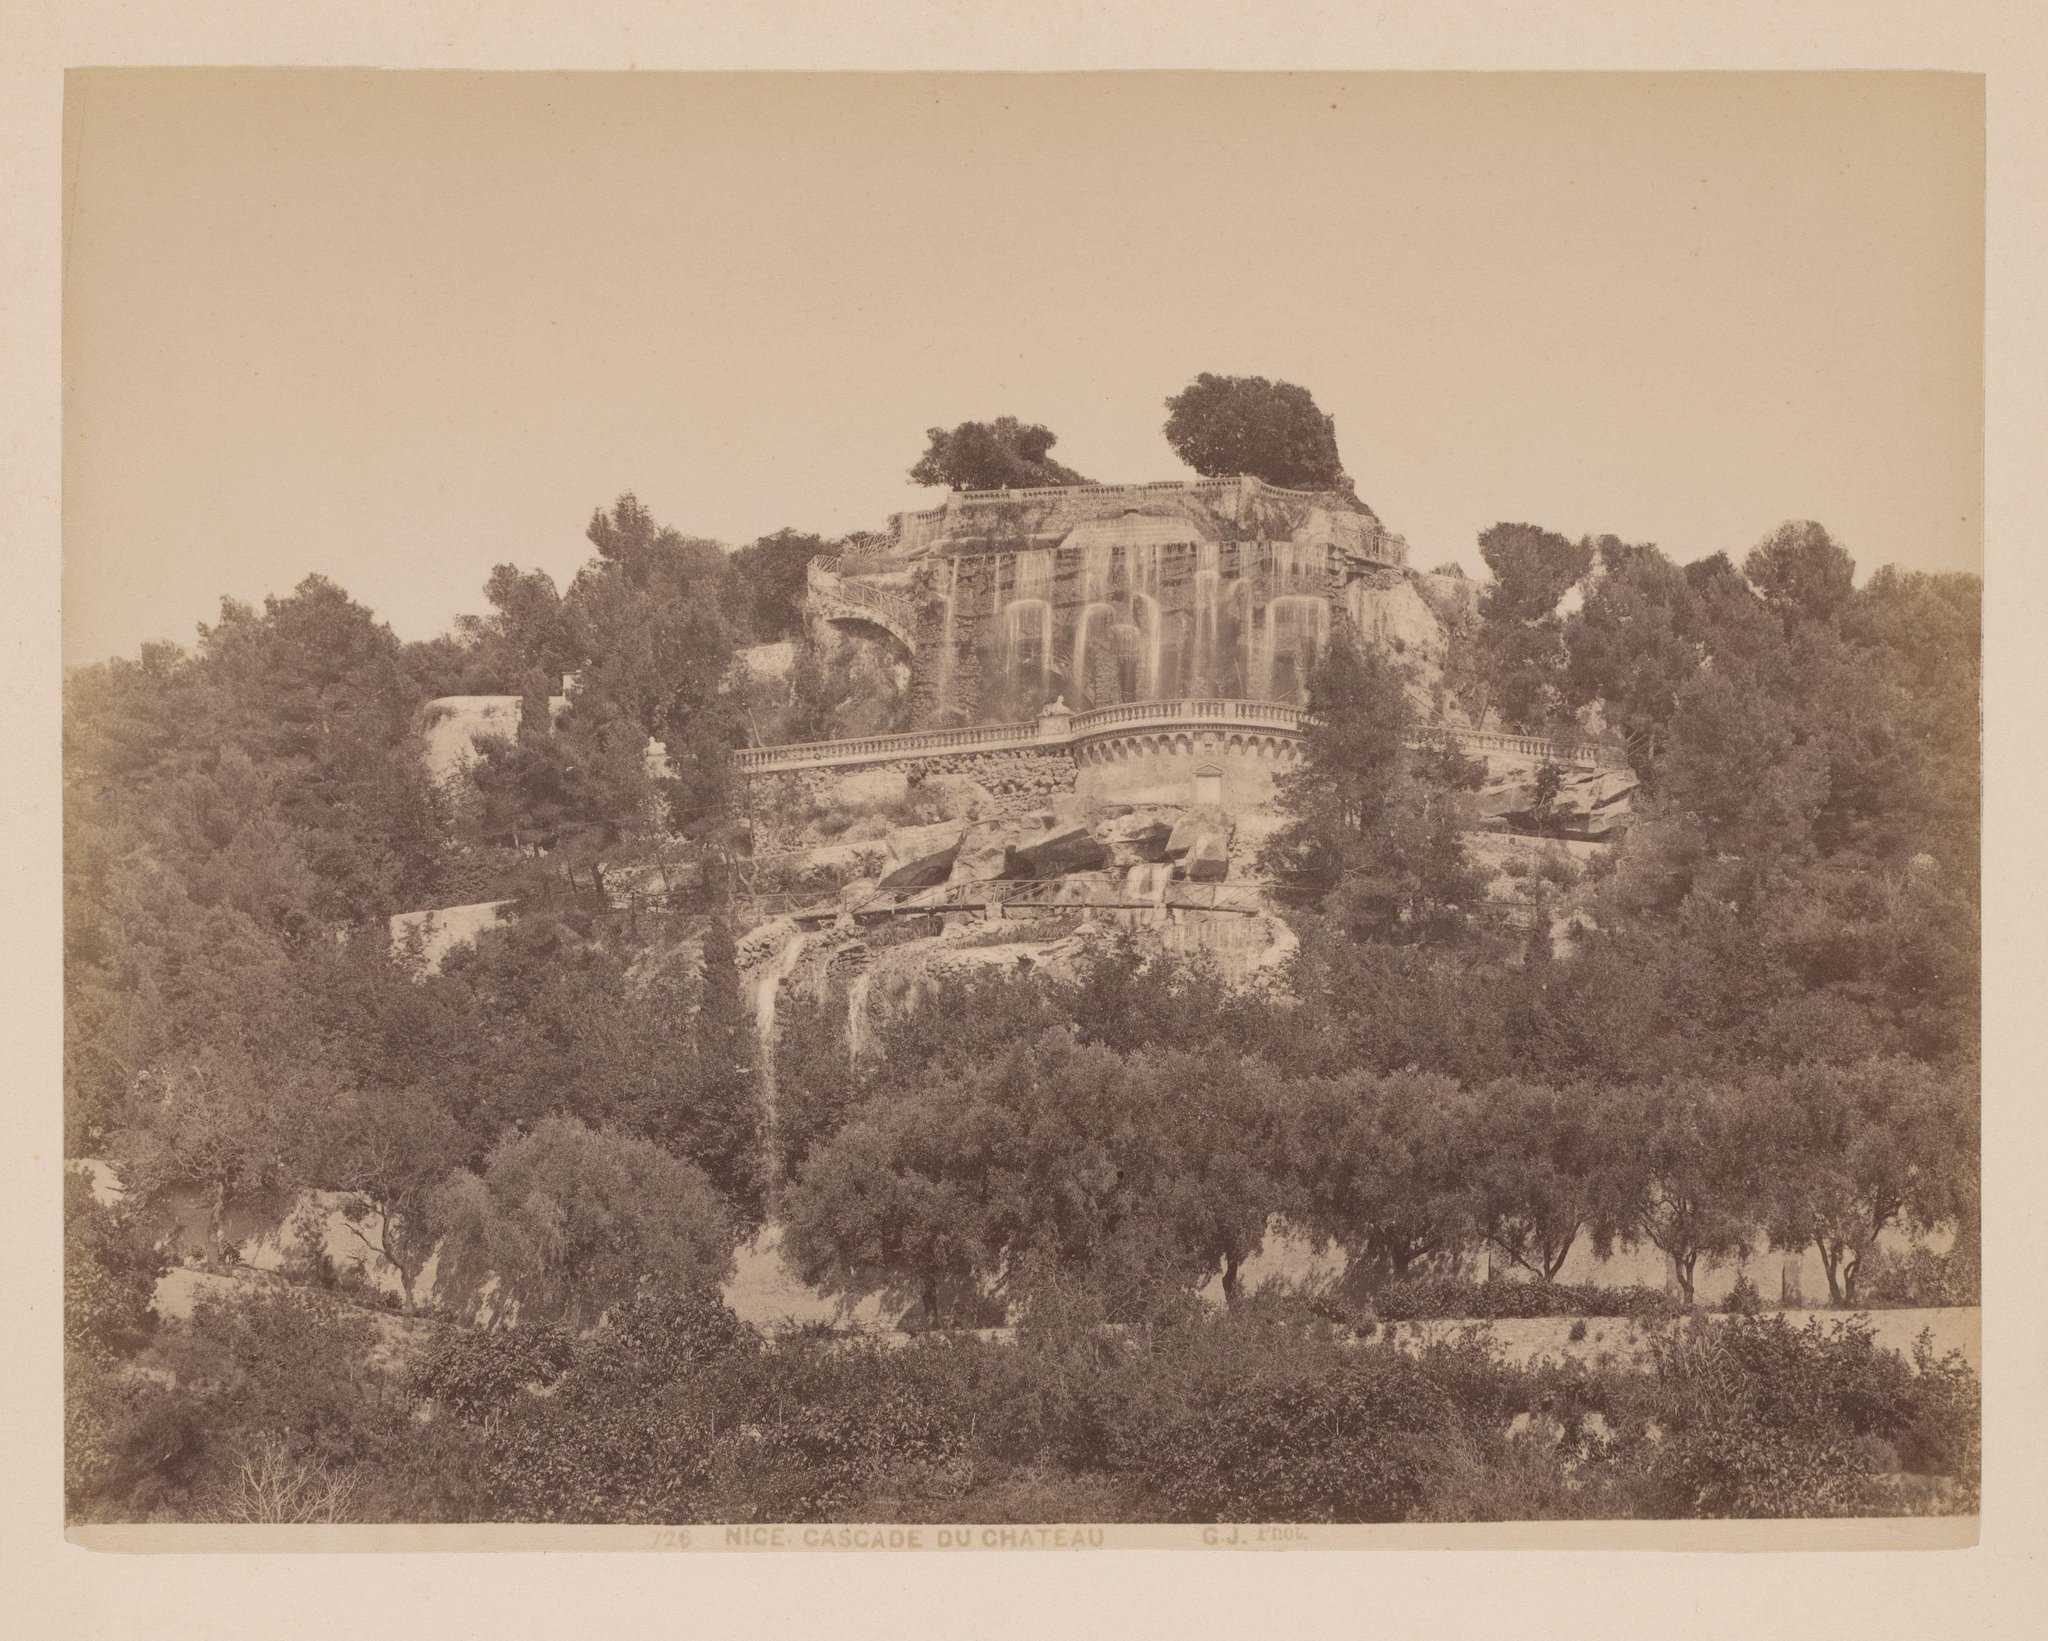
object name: photograph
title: Cascade du Chateau, Nice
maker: jean gilletta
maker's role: fotograaf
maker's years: 1856-1933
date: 1880-1900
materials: cardboard, photographic support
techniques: albumen print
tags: nice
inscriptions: inscription: ‘G.J. Phot.’, inscription: ‘726 NICE. CASCADE DU CHATEAU’